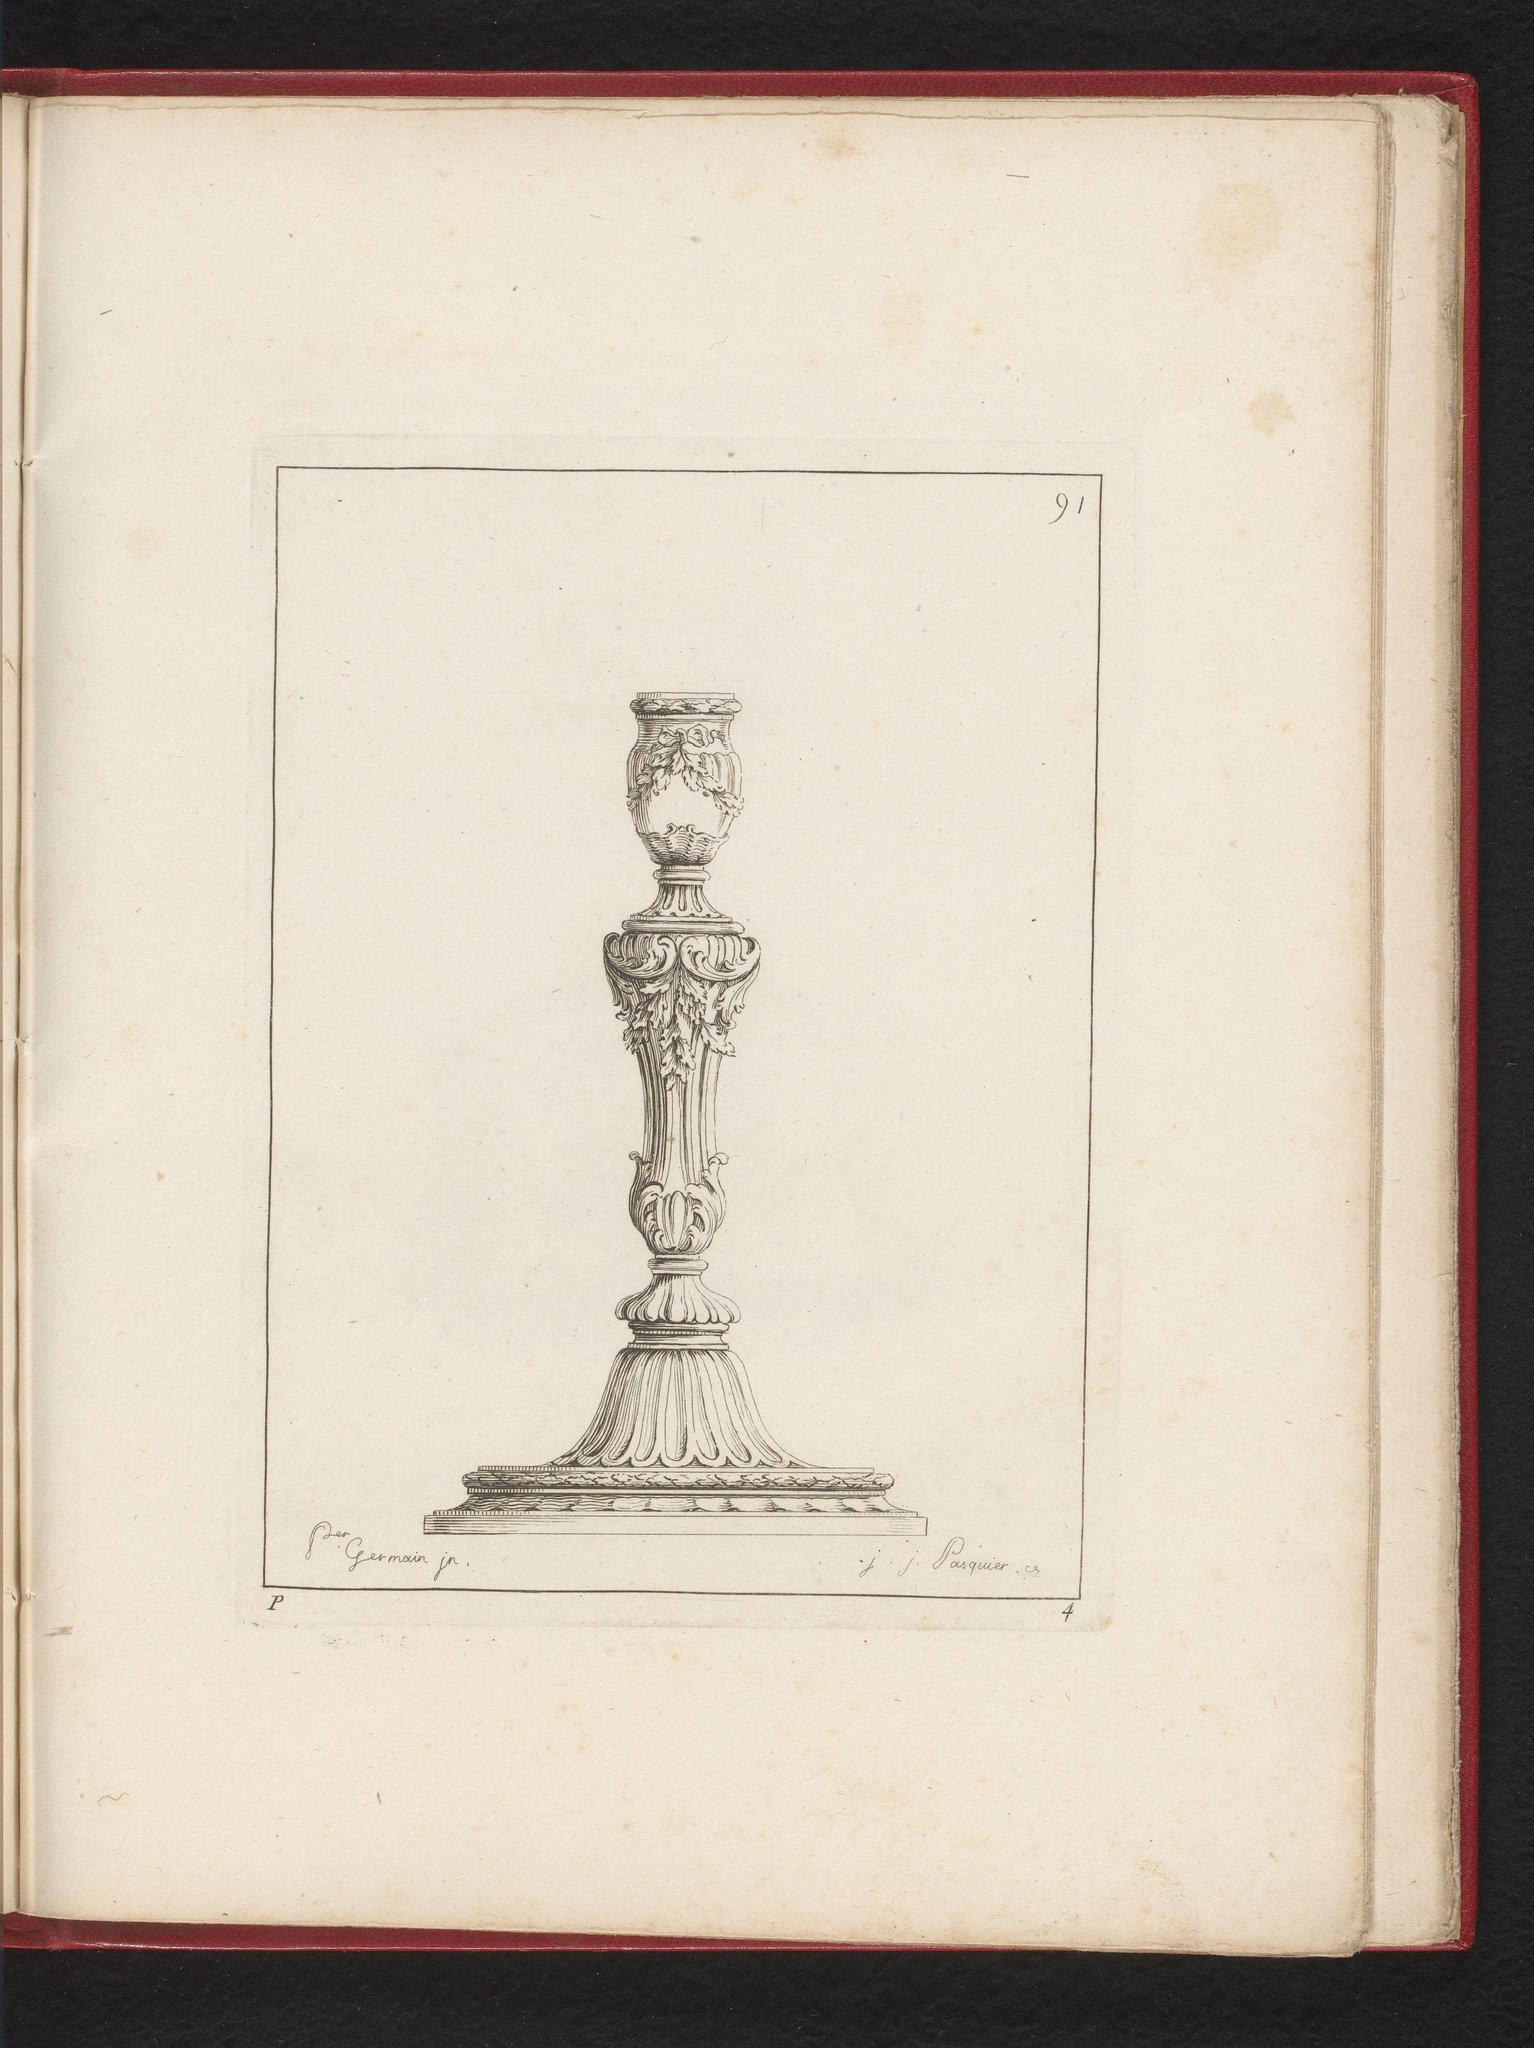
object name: print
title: Ontwerp voor een kandelaar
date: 1748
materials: paper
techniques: etching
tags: candlestick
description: Een aantal van de objecten in deze reeks heeft een eigen ondertitel, die verwijst naar genummerde 'cahiers' (afleveringen) waarin de prenten werden uitgegeven. Het is onduidelijk welke objecten recies bij welke aflevering horen. Daarom is die ondertitel enkel verwerkt bij de prent waarop die voorkomt.